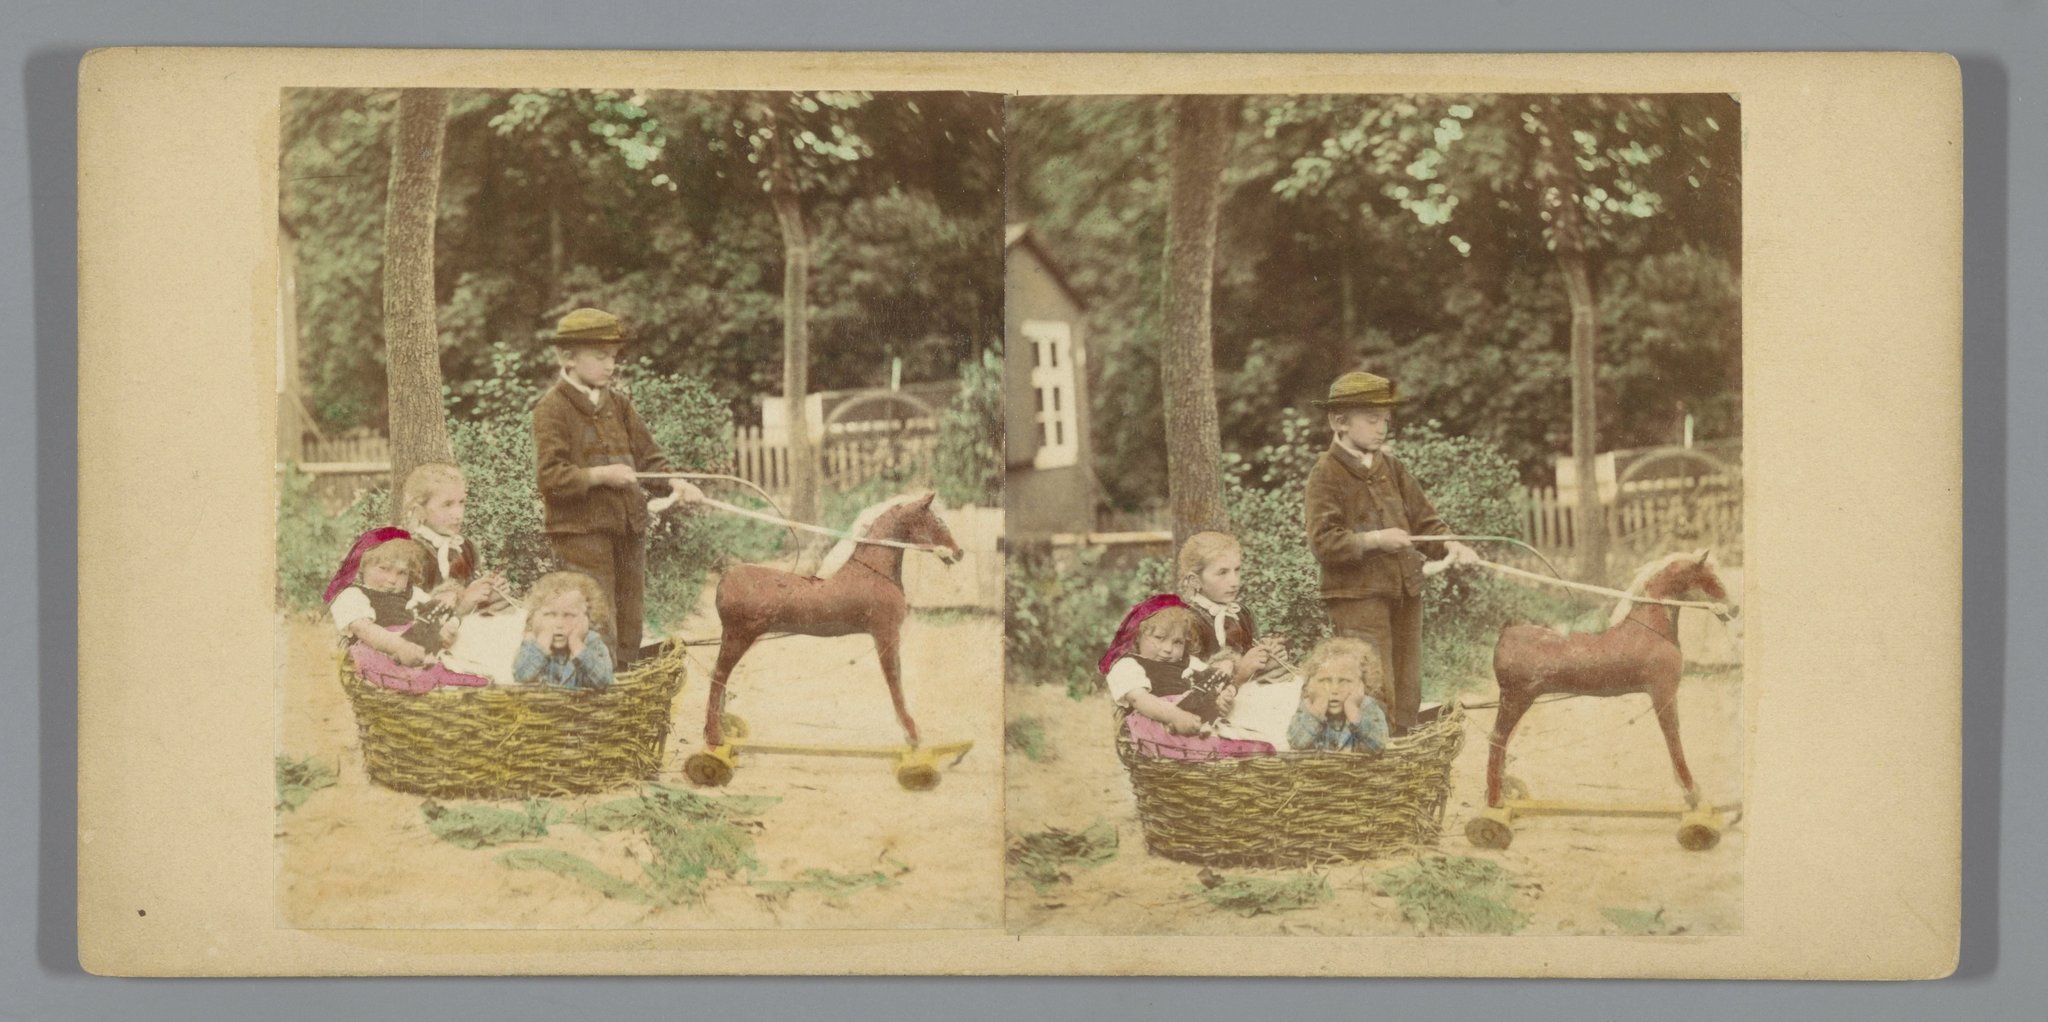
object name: stereograph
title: Spelende kinderen in een tuin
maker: Anonymous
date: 1852-1863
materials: cardboard, paper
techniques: albumen print, hand coloring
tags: (playing with) movable toys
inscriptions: inscription: ‘359’